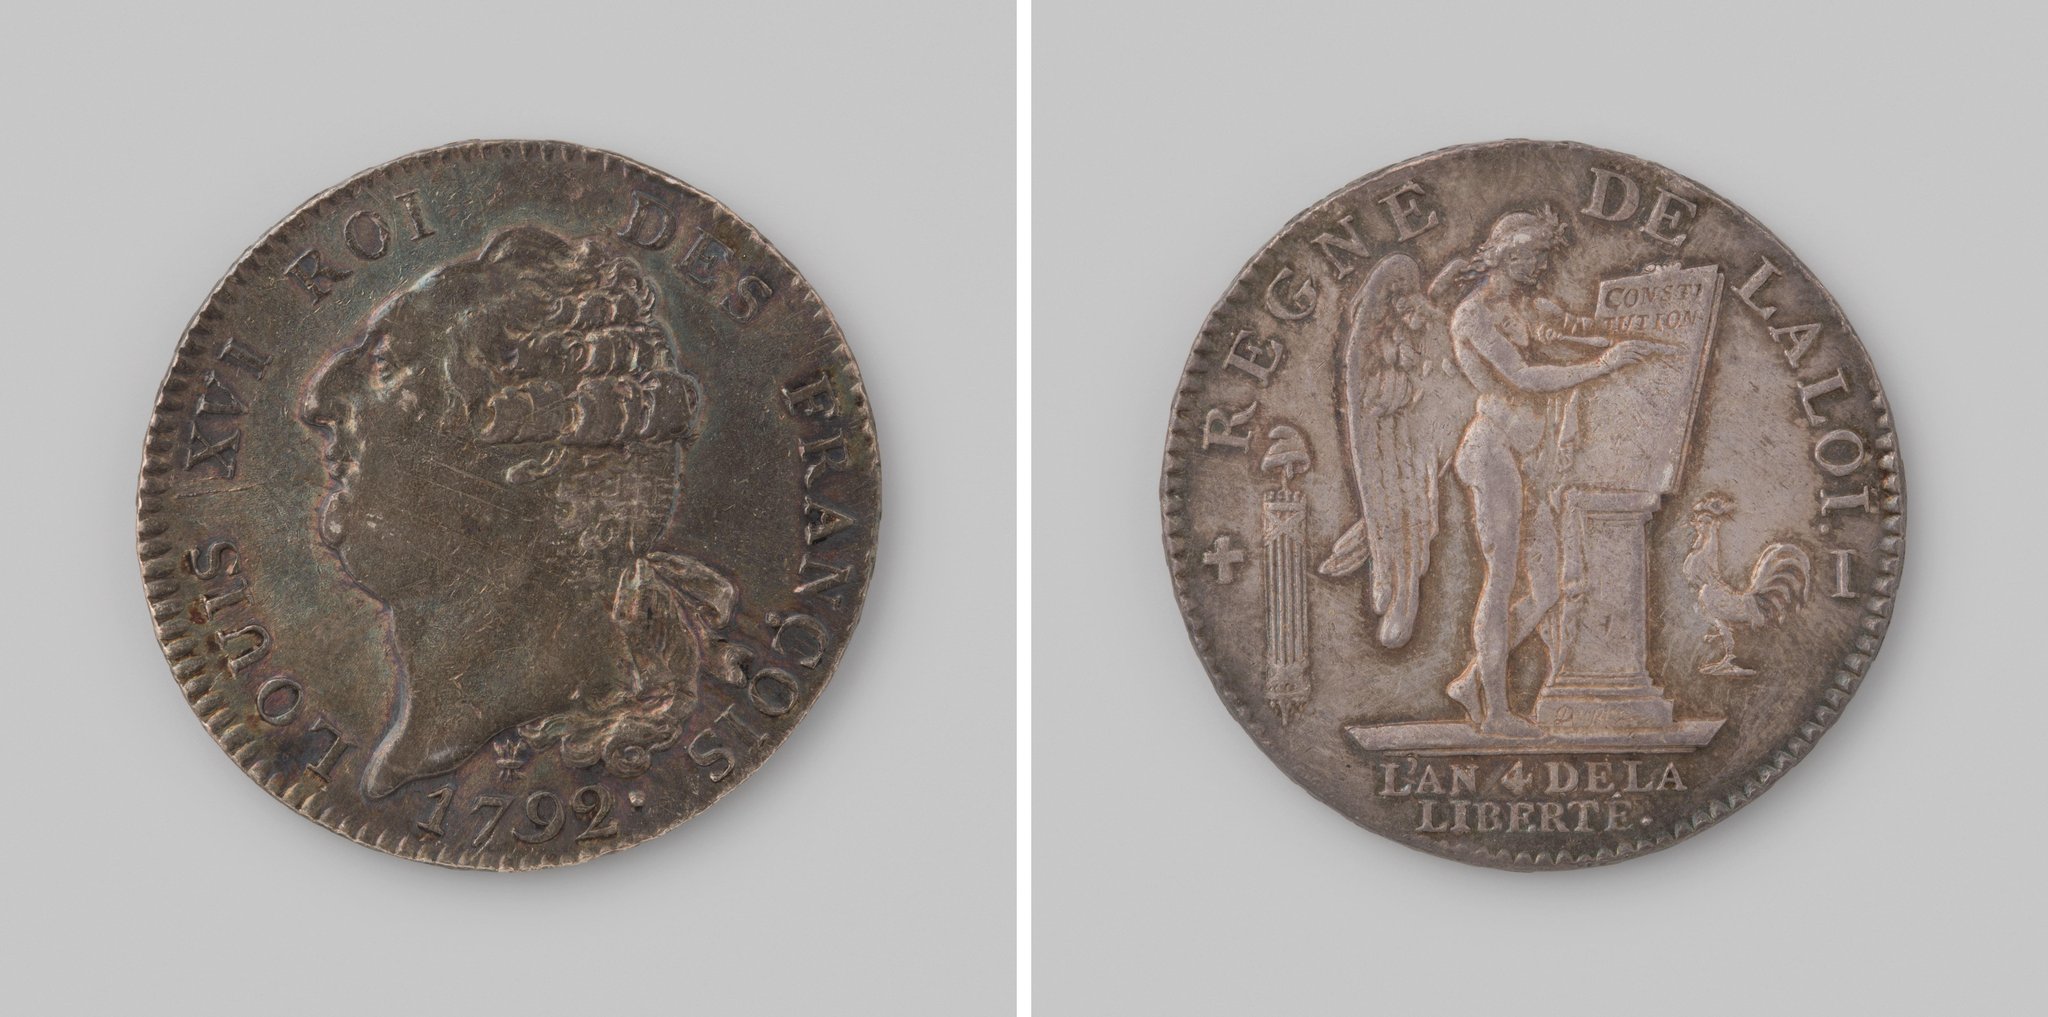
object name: coin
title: Frankrijk, écu of 6 livres, Lodewijk XVI, 1792 I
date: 1792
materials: silver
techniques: striking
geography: limoges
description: Zilveren munt. Voorzijde: borstbeeld van de koning naar links. Daaronder jaartal. Keerzijde: gevleugelde jongeling naar rechts die op een op voetstuk staand bord in twee regels schrijft: constitution. Links en rechts van hem attributen. Uiterst rechts de letter I [=Limoges]. In afsnede jaartal 4 in nieuwe telling. Randschrift.